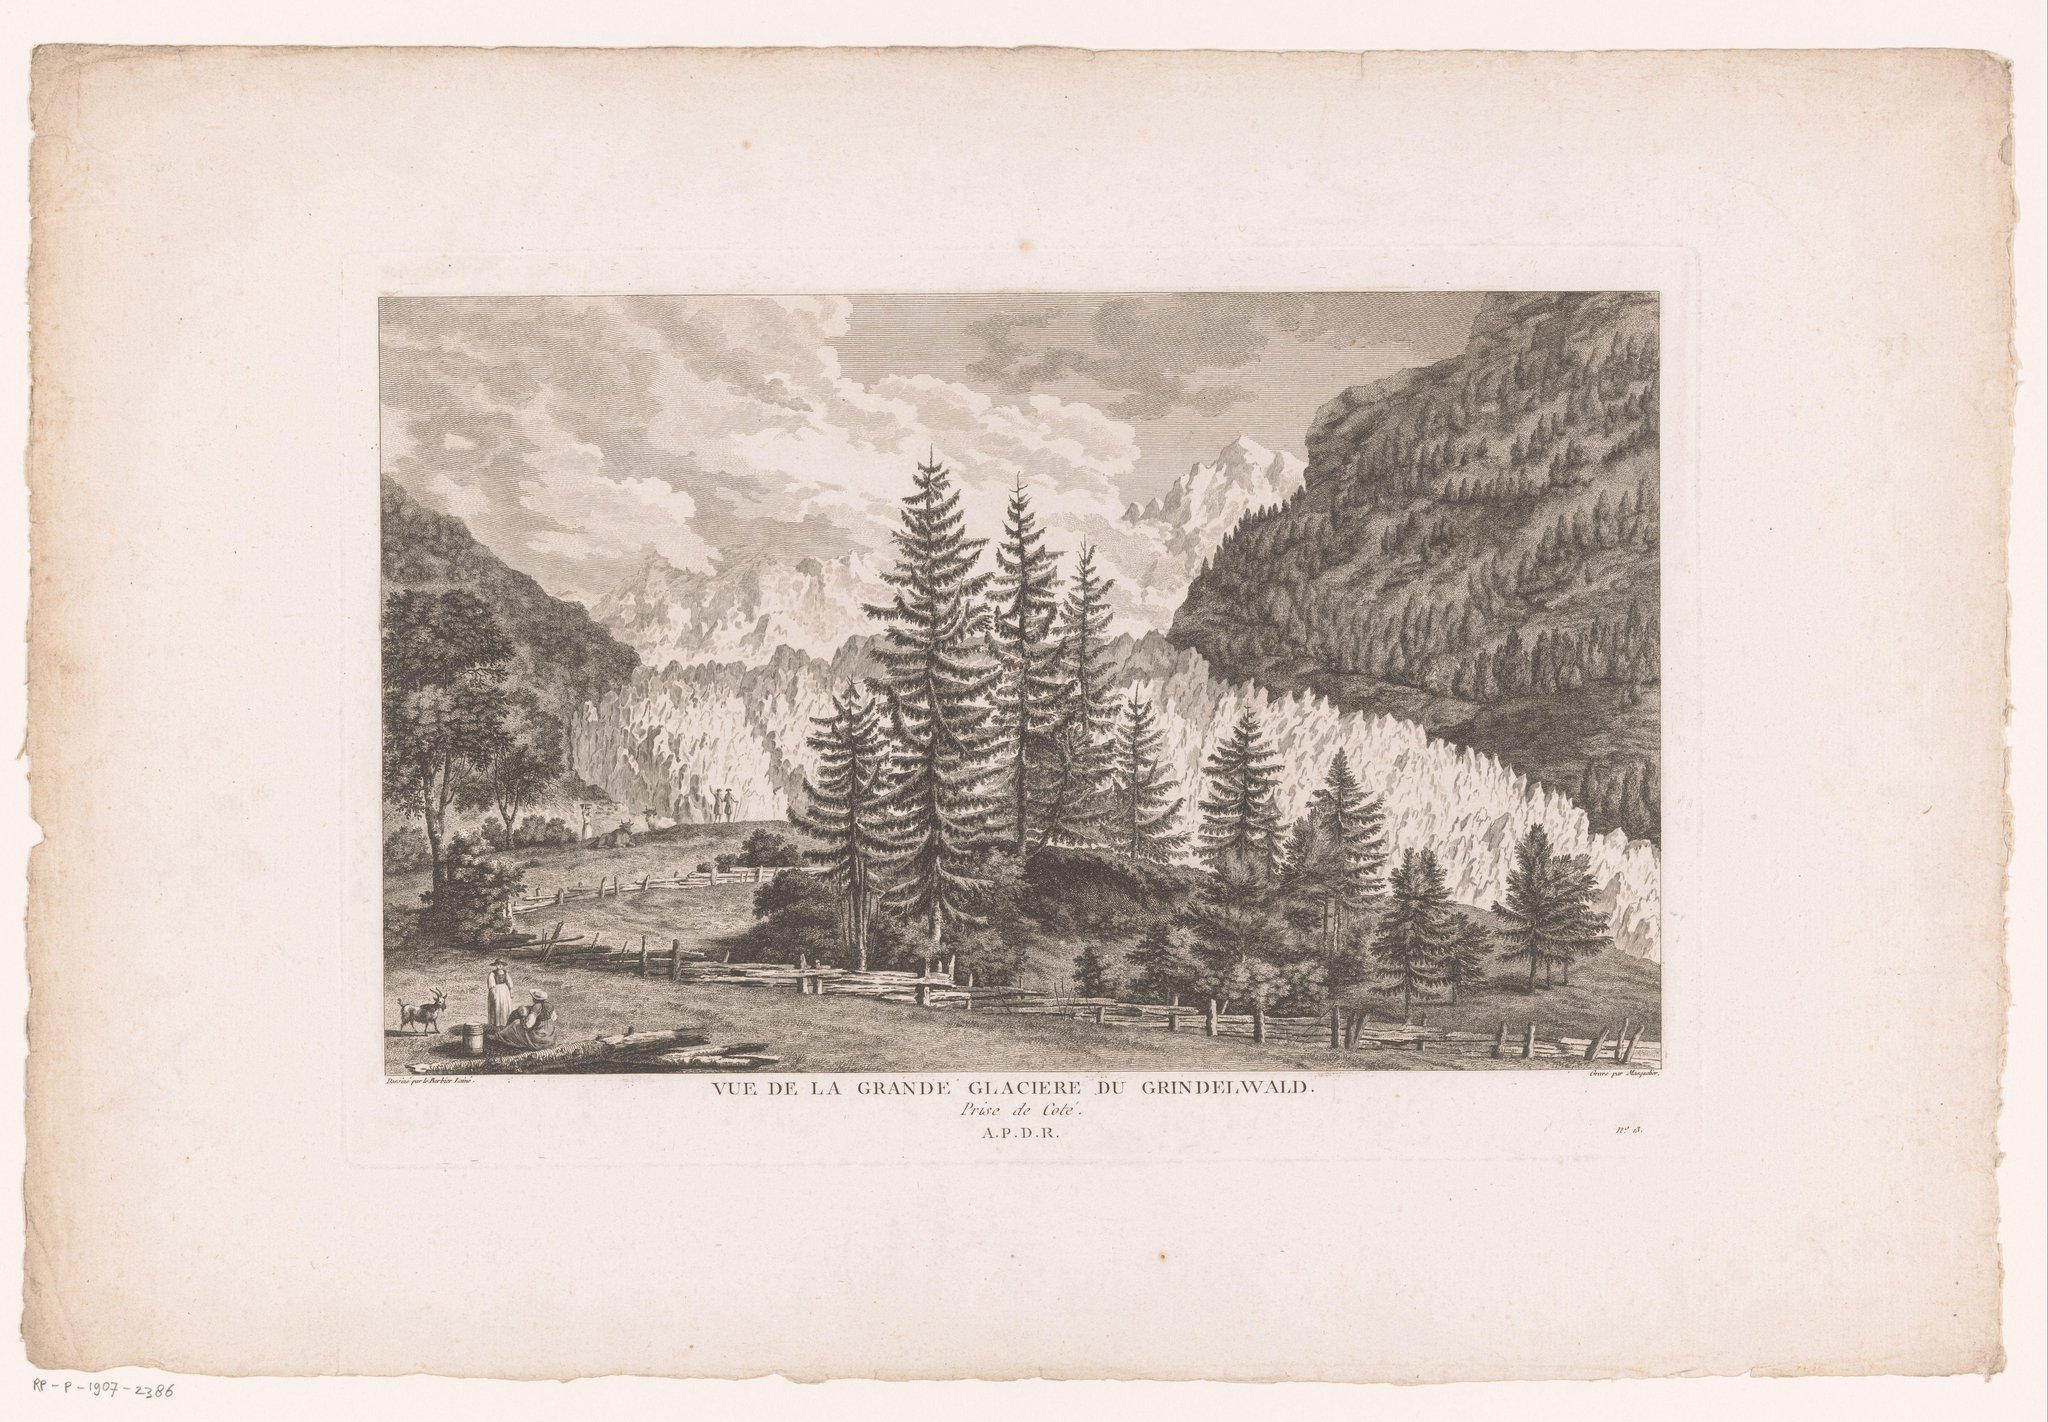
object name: print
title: Vue de la grande glacière du Grindelwald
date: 1751-1811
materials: paper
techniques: etching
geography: france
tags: glacier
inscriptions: collector's mark: Lugt 2228